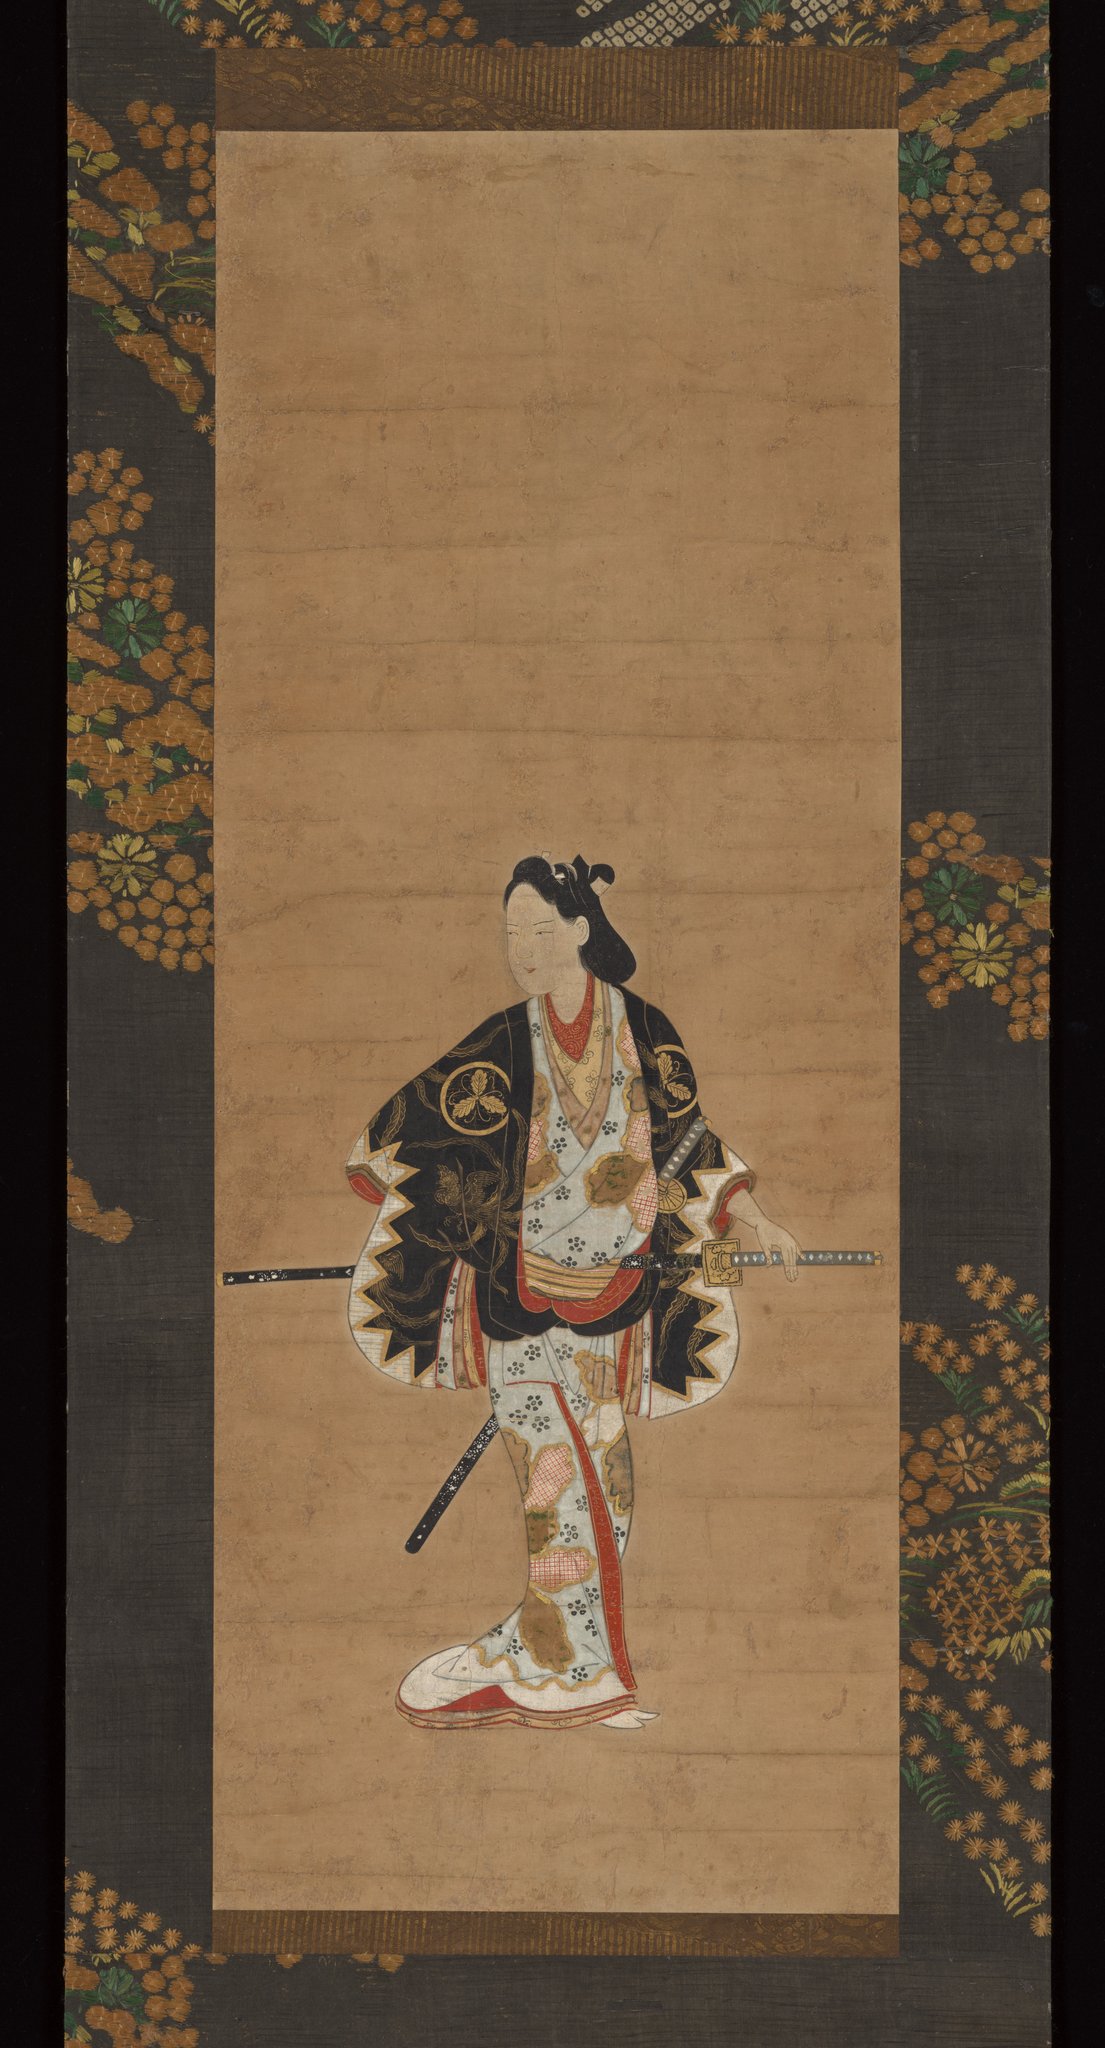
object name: hanging scroll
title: Wakashu (Male Youth) with Two Swords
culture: japanese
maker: unidentified artist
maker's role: artist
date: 1667-1700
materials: ink, silk